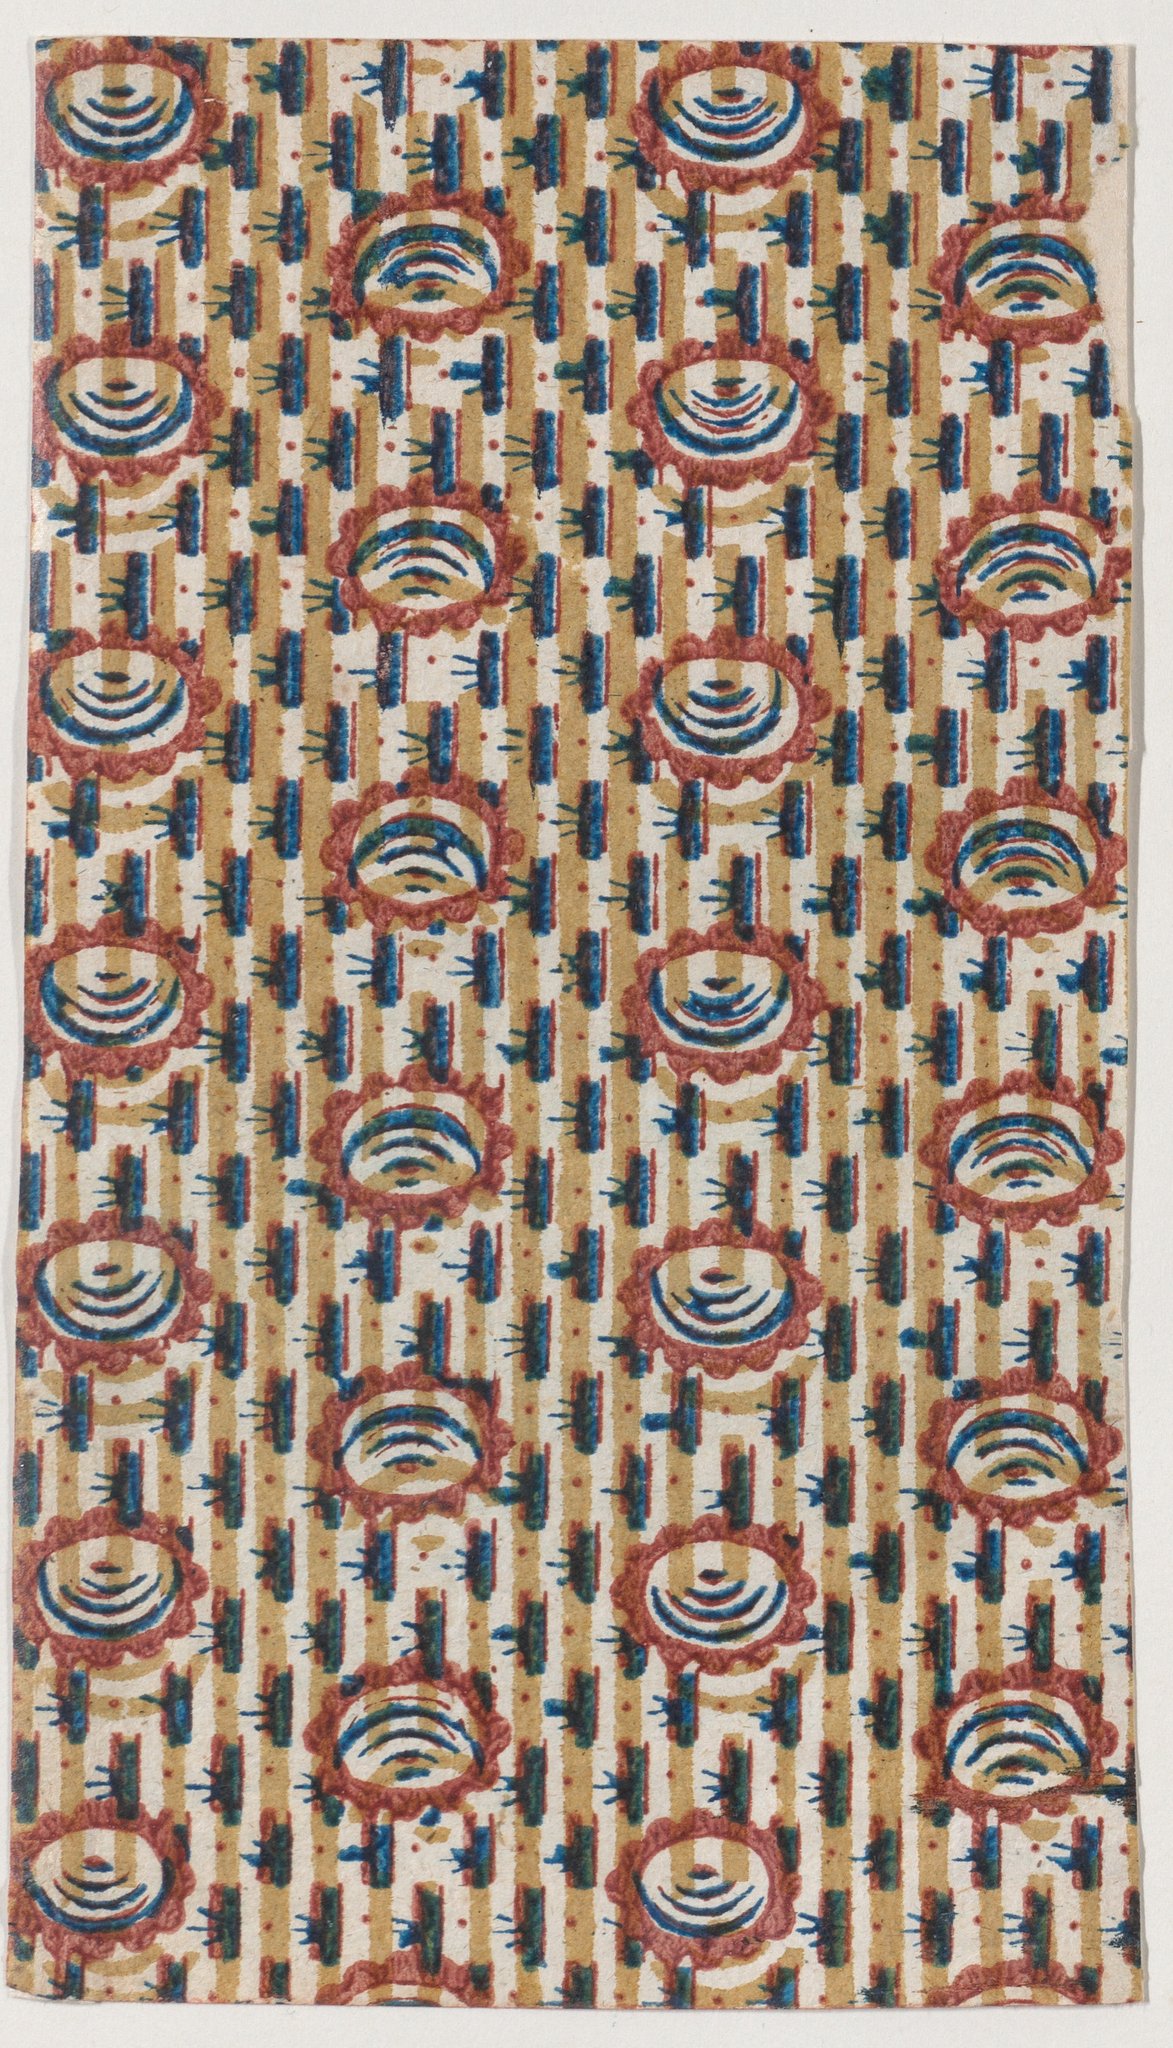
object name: print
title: Sheet with abstract and stripe pattern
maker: Anonymous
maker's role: artist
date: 1801-1900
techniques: relief print